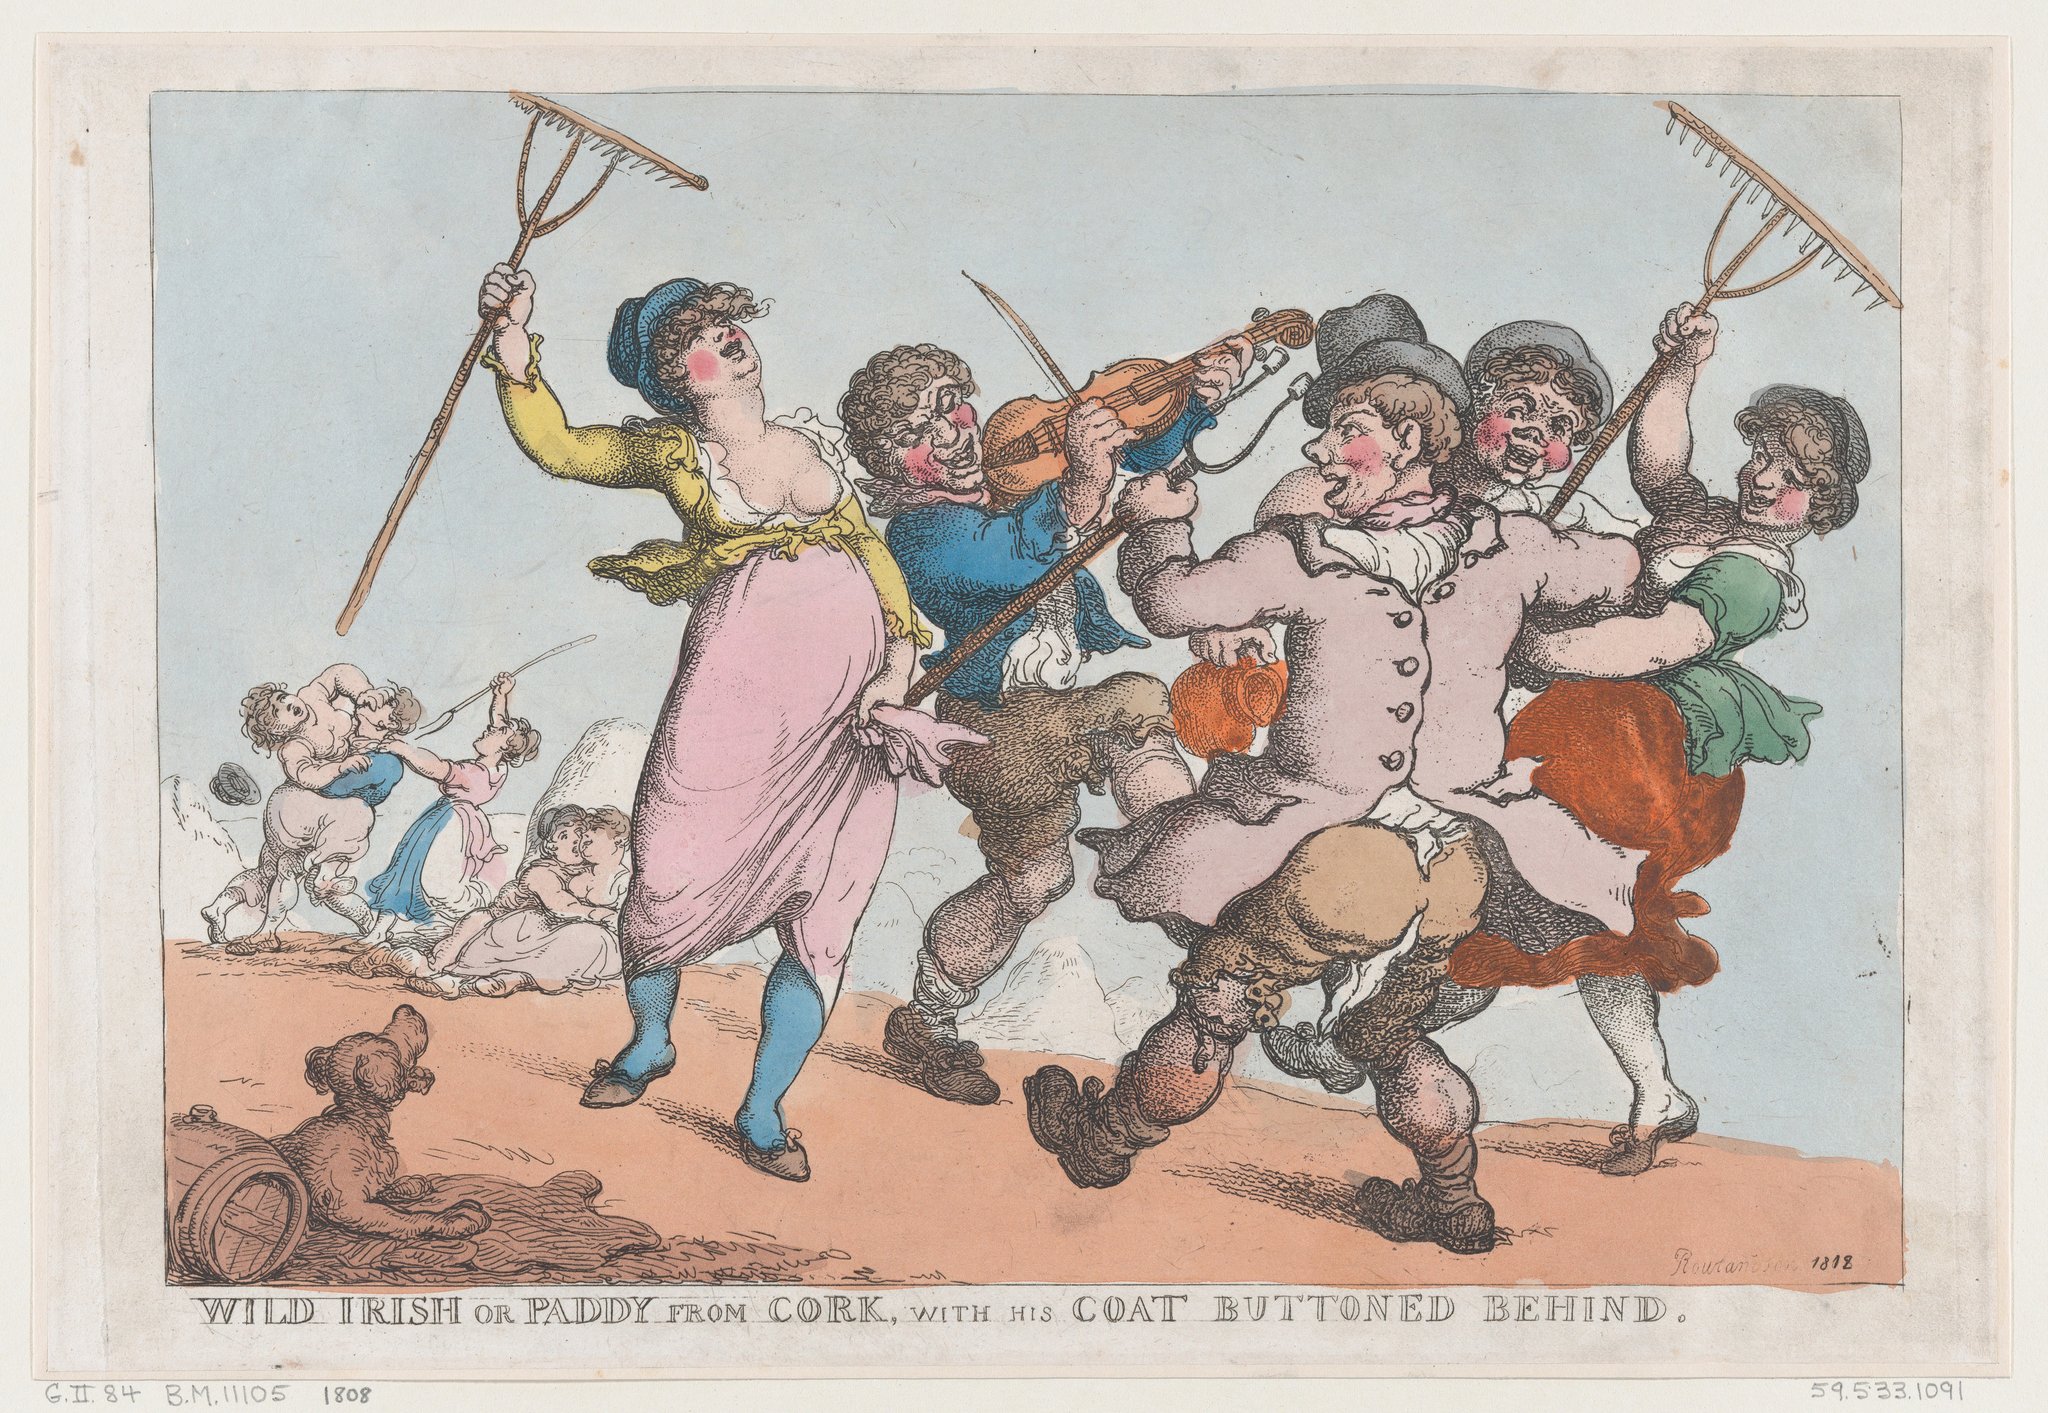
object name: print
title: Wild Irish, or Paddy from Cork with his Coat Buttoned Behind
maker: thomas rowlandson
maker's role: artist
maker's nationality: british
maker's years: 1757-1827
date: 1818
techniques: etching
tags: satire,men,women,dancing,musicians